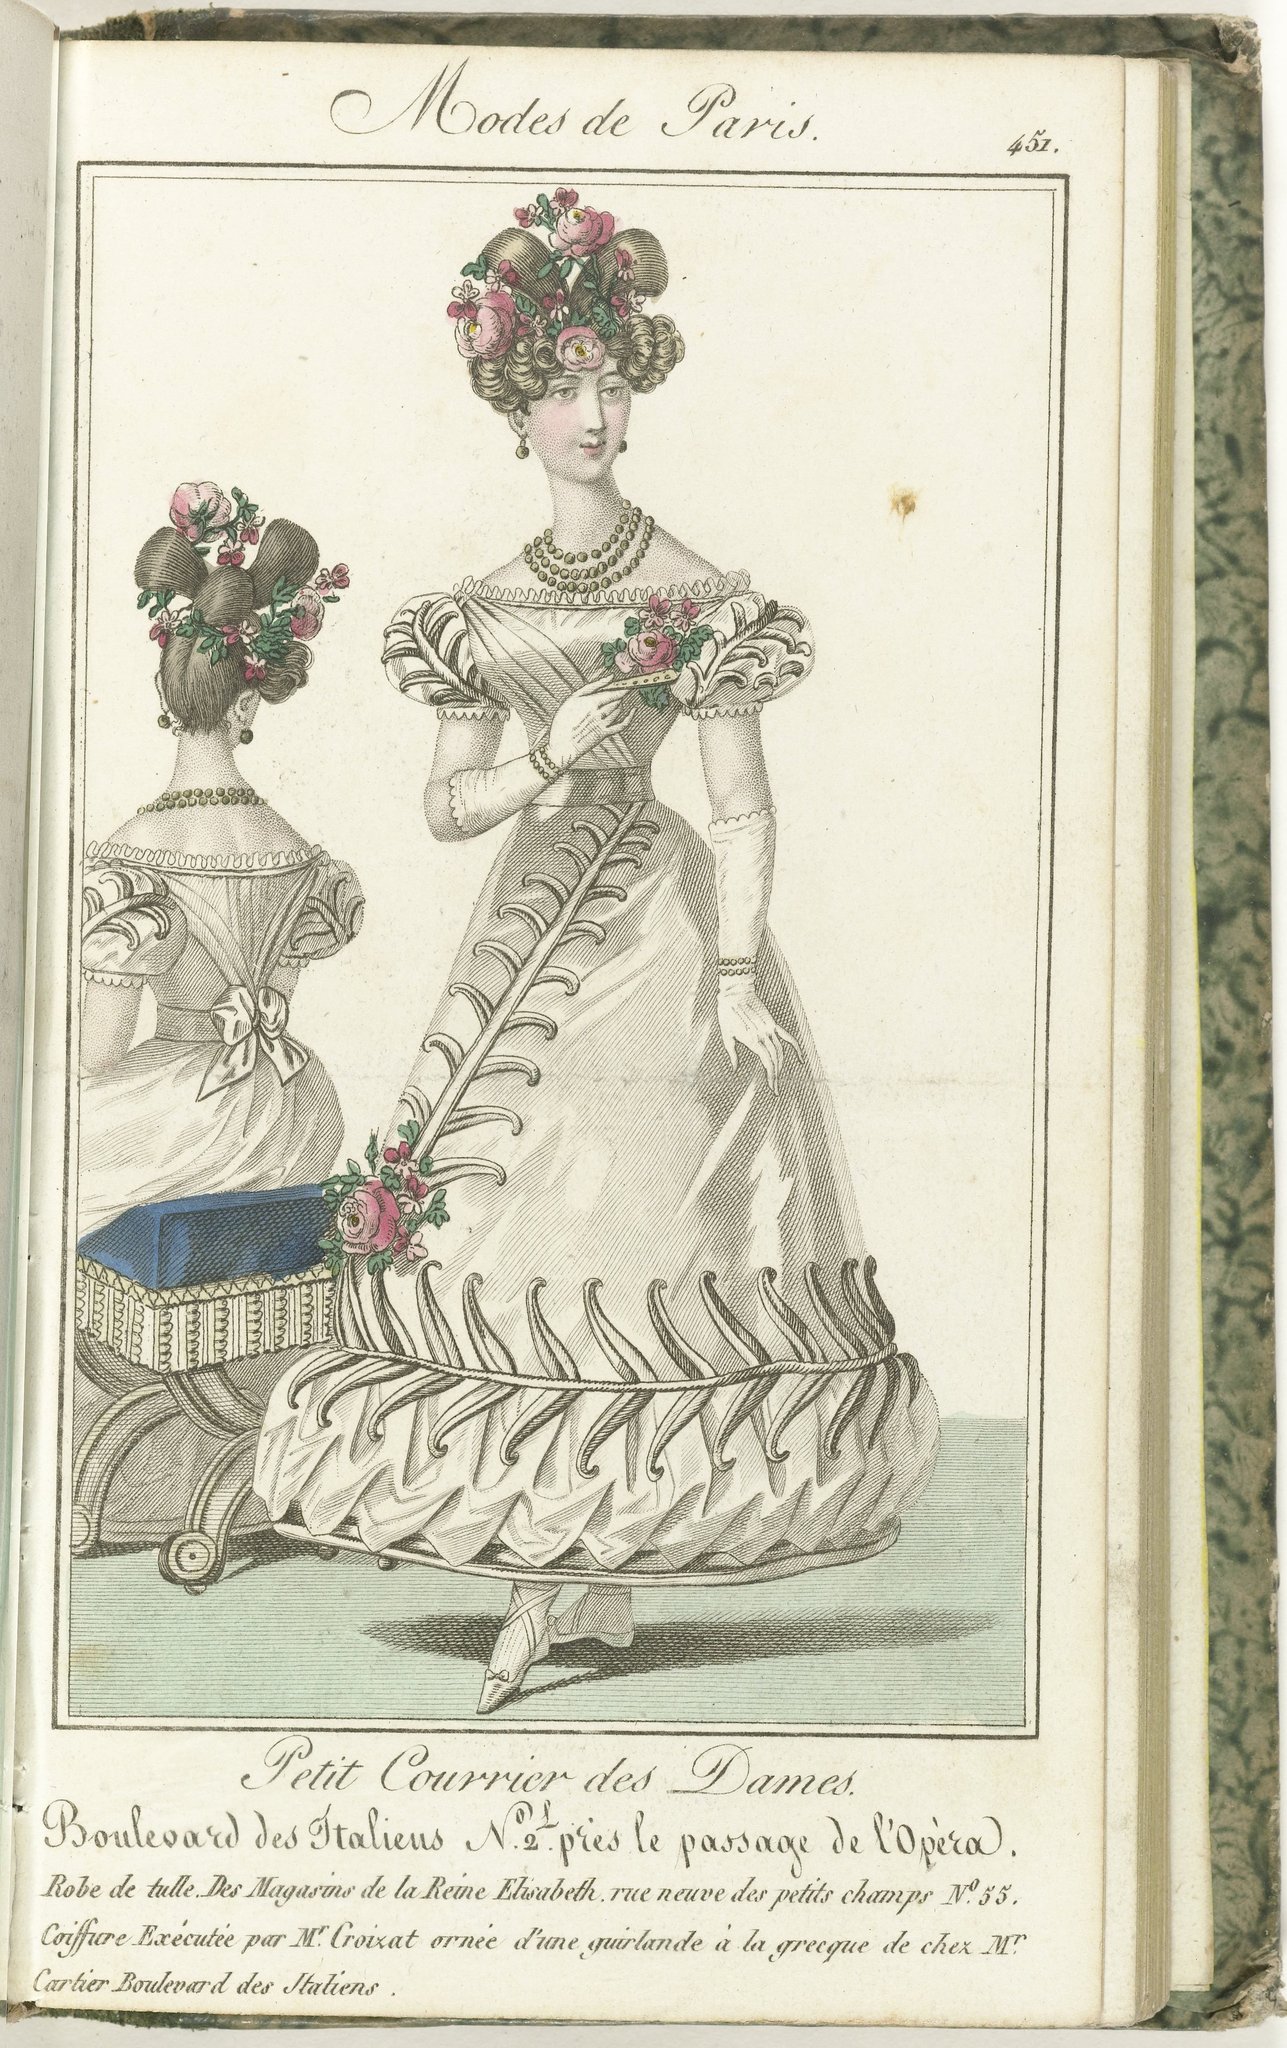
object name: fashion print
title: Petit Courrier des Dames, 25 février 1827, No. 451 : Robe de tulle. Des Magasins de la Reine Elisabeth...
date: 1827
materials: paper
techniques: engraving, hand coloring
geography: paris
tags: corsage (+ women's clothes), flowers, gloves, mittens (long gloves) (+ women's clothes), styles of hairdress - aa - ~ women, fashion plates, shoes, sandals (+ women's clothes), dress, gown (+ women's clothes), fan (+ women's clothes), necklace (+ women's clothes)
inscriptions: title: ‘Modes de Paris.’, title: ‘Petit Courrier des Dames.’, address: ‘Boulevard des Italiens No.2 près le passage de l'Opèra.’, caption: ‘Robe de tulle. Des Magasins de la Reine Elisabeth, rue neuve des petits champs No. 55. Coiffure Exécutée par M.r Croizat ornée d'une guirlande à la grecque de chez M.r Cartier Boulevard des Italiens.’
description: Staande vrouw in een japon van tule van de 'magasins de la Reine Elisabeth'. Coiffure uitgevoerd door Croizat, versierd met een guirlande 'à la grecque' van Mr Cartier. Dezelfde japon op de rug gezien. Prent uit het modetijdschrift Petit Courrier des Dames (1821-1868). Ingebonden (met enkele pp. Le Journal des Dames et des Modes). 15 Januari 1827 t/m 20 maart 1830. Incompleet.